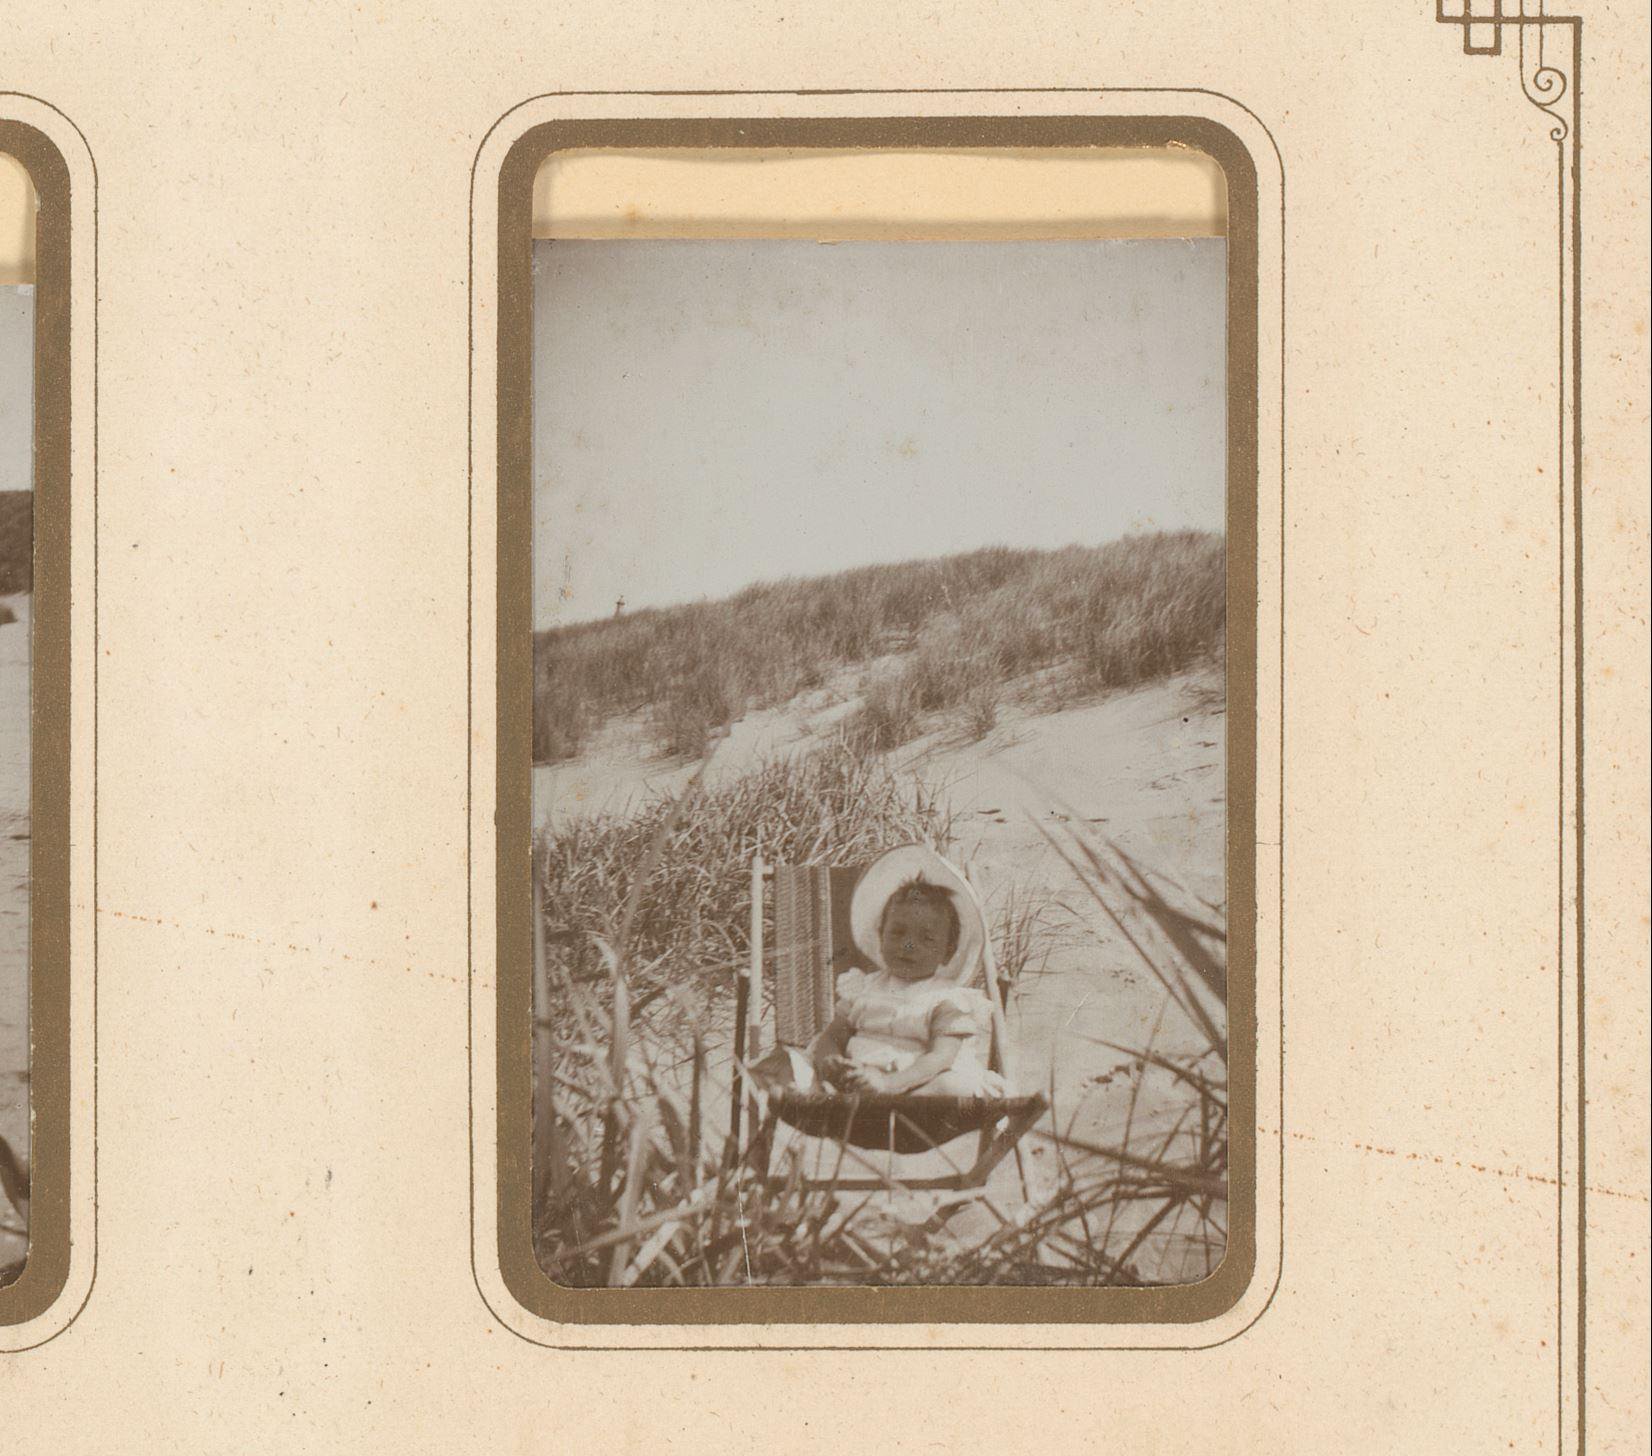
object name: album leaf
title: Peuter in een stoel op het strand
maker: Anonymous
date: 1890-1920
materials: cardboard, photographic support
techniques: collodion silver print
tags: beach (as place of recreation), toddler, historical persons